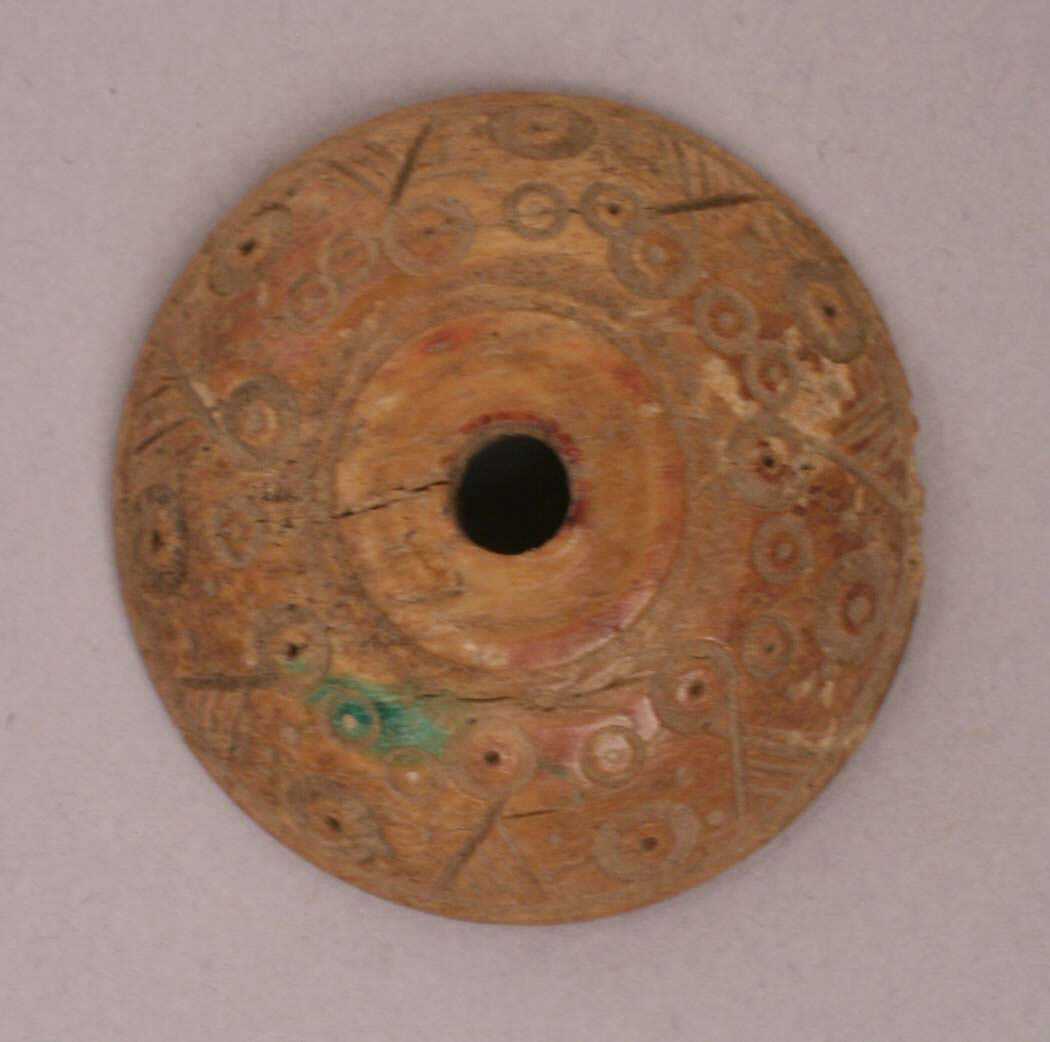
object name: button or bead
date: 801-1000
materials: bone, paint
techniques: incising, inlay, tinting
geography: iran